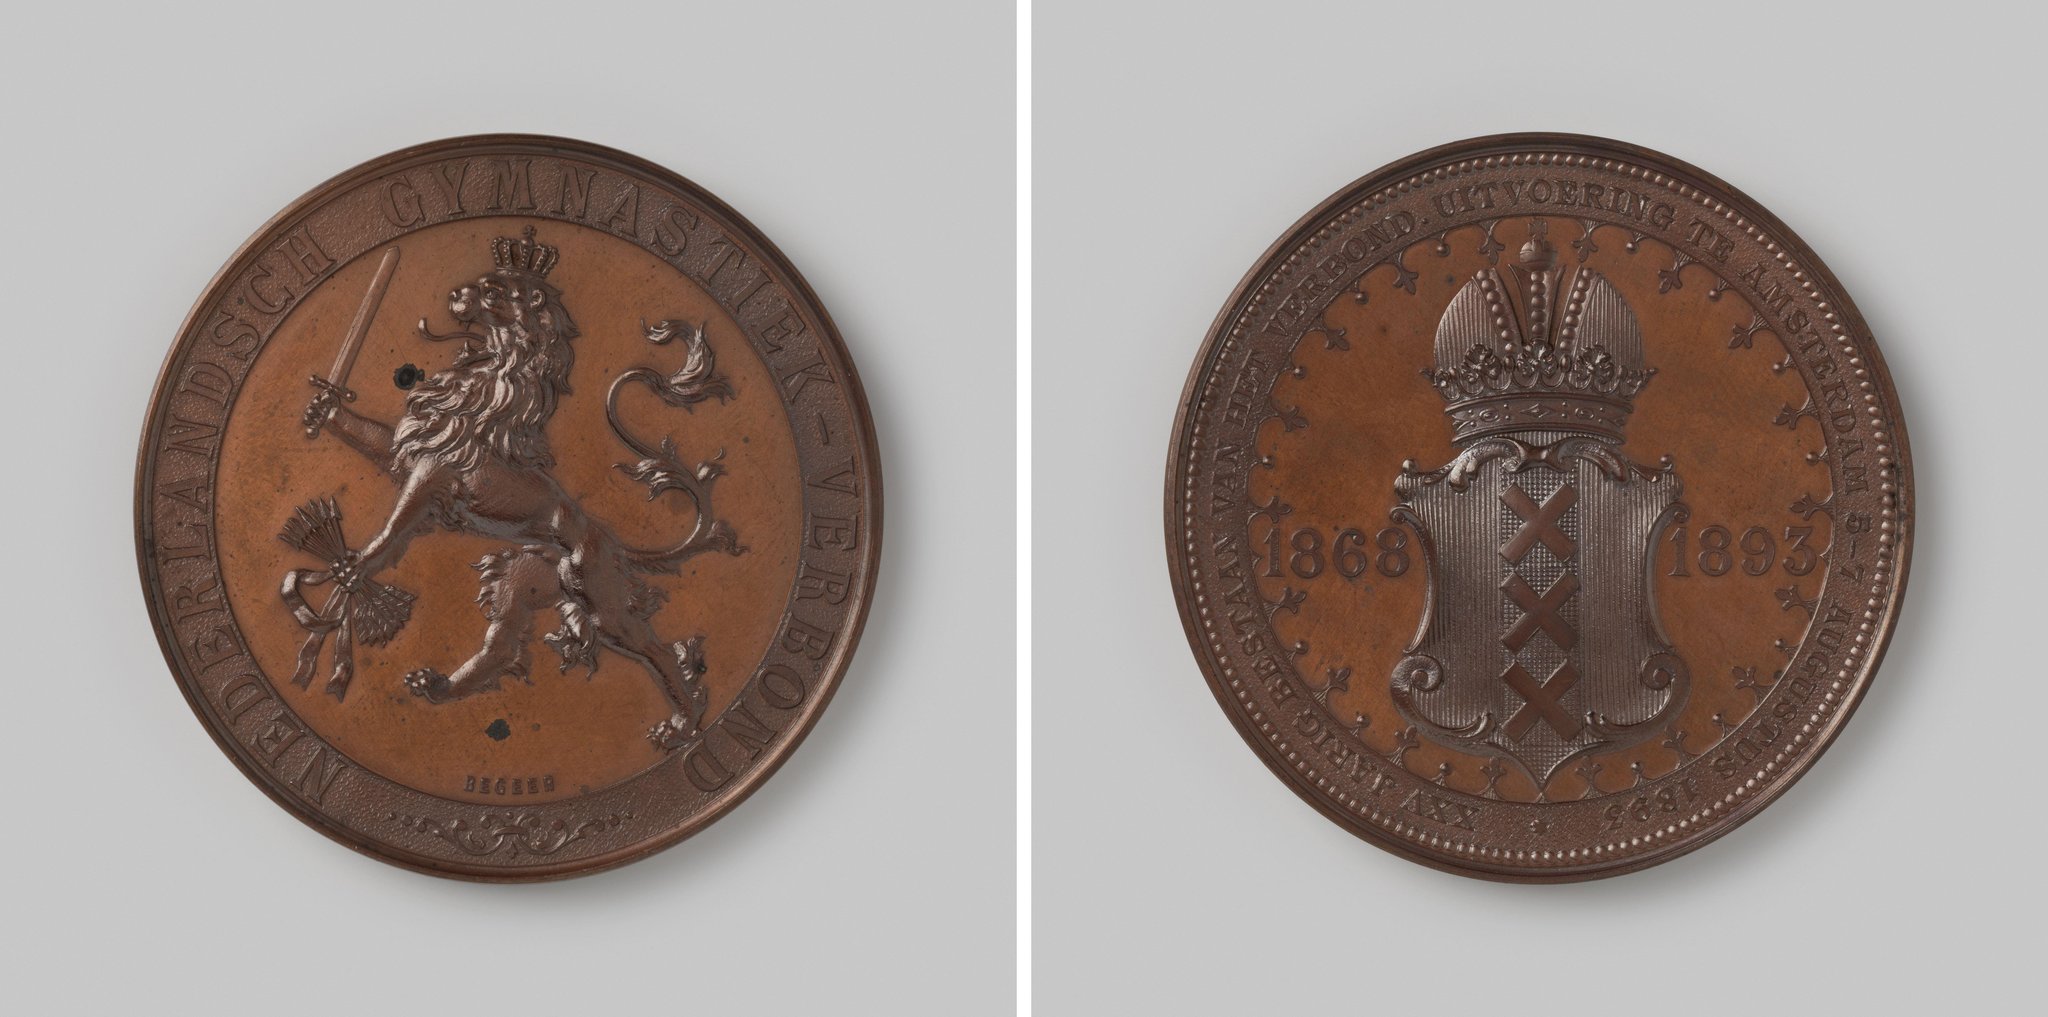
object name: history medal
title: Uitvoering in Amsterdam en vijfentwintigjarig bestaan van het Nederlandsch Gymnastiek-Verbond 1893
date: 1893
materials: bronze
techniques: striking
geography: utrecht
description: Bronzen penning, op de voorzijde de gekroonde Nederlandse leeuw met zwaard en pijlenbundel klimmend naar links, met omschrift, op de keerzijde het gekroonde Amsterdamse wapenschild tussen twee jaartallen binnen een gotisch versierde cirkel, met omschrift.